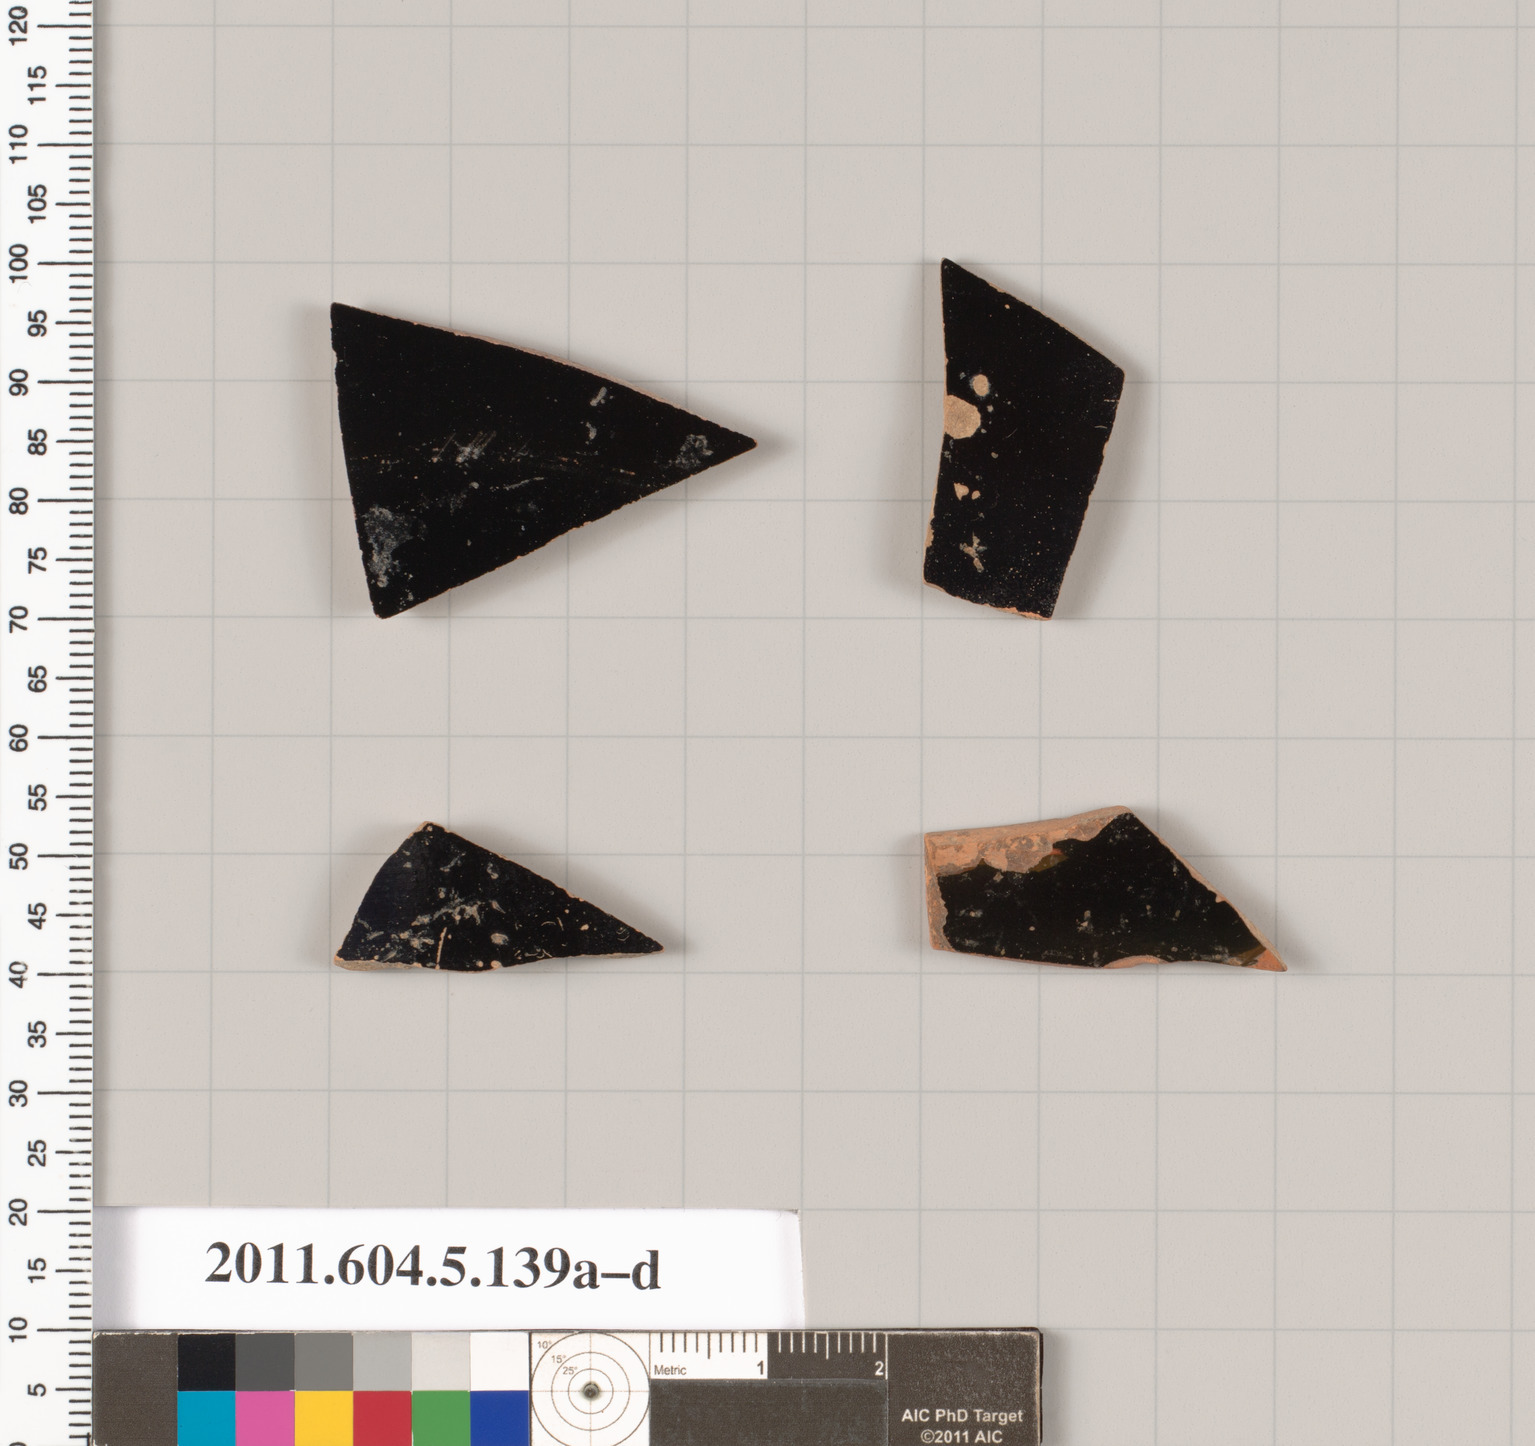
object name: kylix fragment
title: Terracotta fragments of kylikes (drinking cups)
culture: greek, attic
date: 600-401 BCE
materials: terracotta